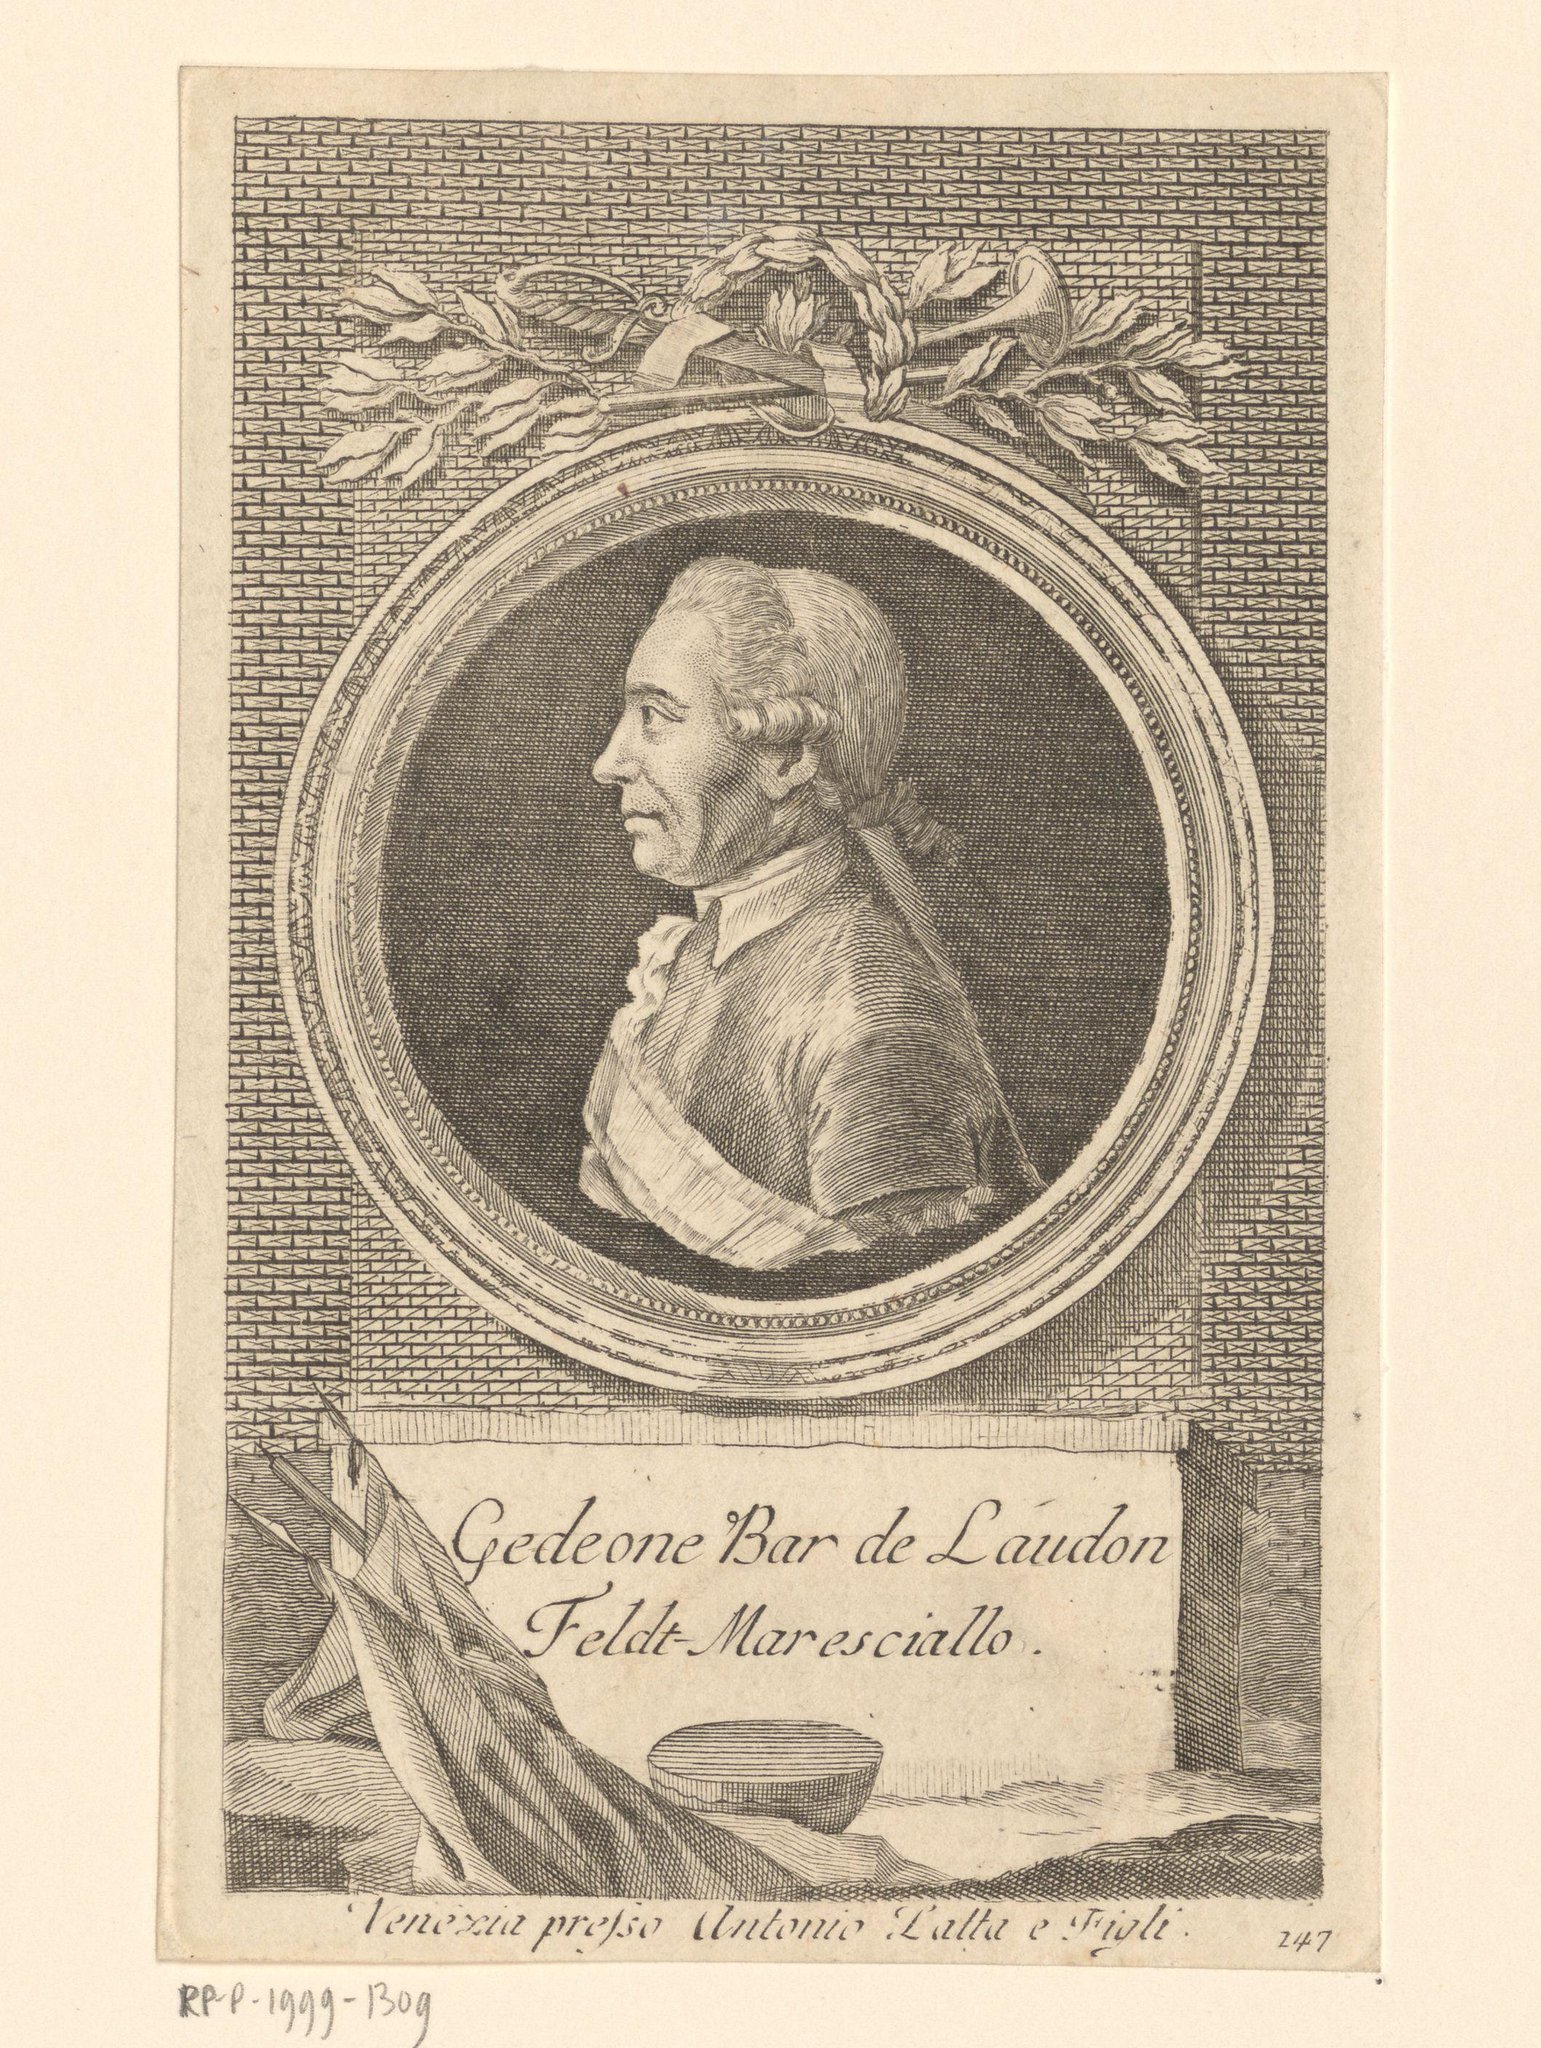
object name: print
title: Portret van Ernst Gideon von Laudon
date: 1758-1799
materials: paper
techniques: engraving, etching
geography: italy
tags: horn, trumpet, cornet, trombone, tuba, ornament ~ medallion, commander-in-chief, general, marshal, historical persons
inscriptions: collector's mark: Lugt 2228, collector's mark: Lugt 2760